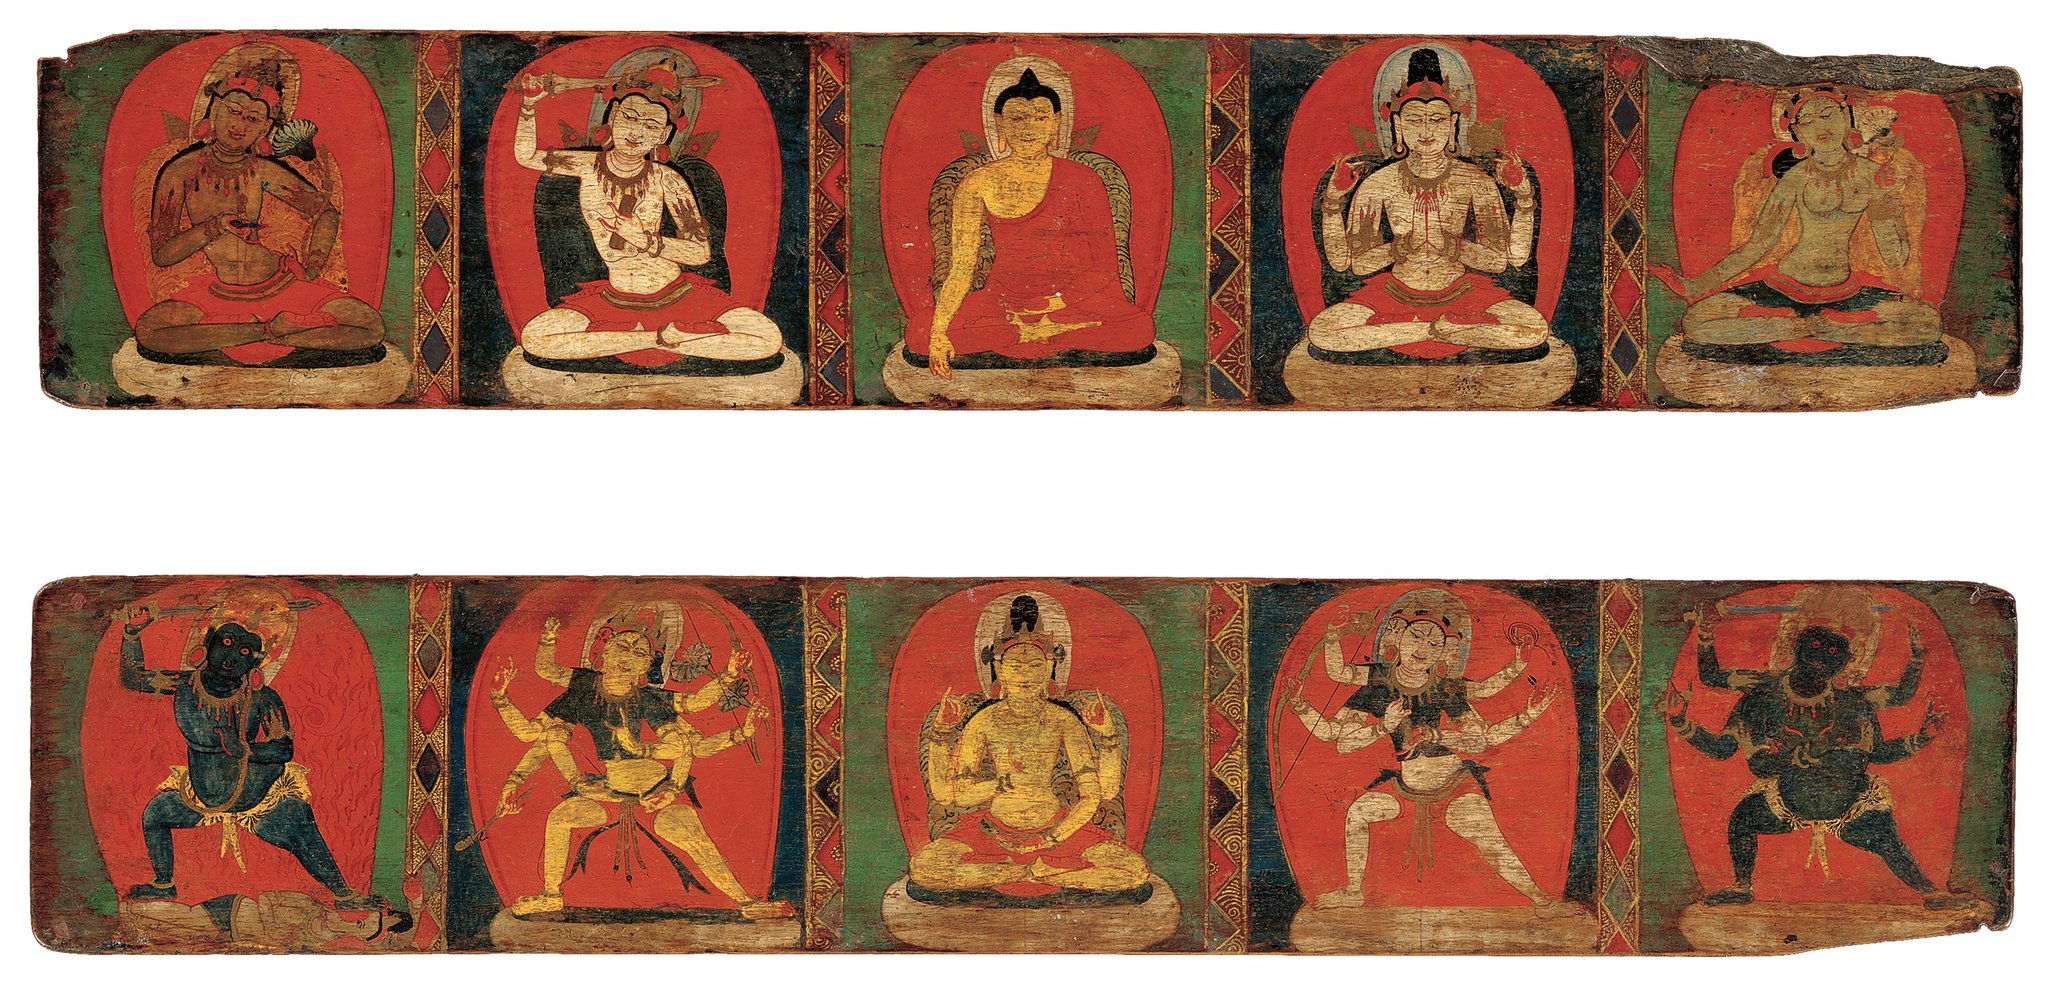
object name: book cover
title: Pair of Manuscript Covers, Each with Five Deities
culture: tibetan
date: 1067-1100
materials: gilt, wood